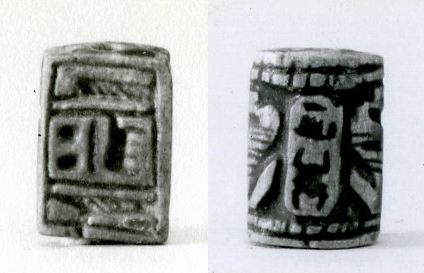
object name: plaque, thutmose iii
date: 1479-1425 BCE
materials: faience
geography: egypt